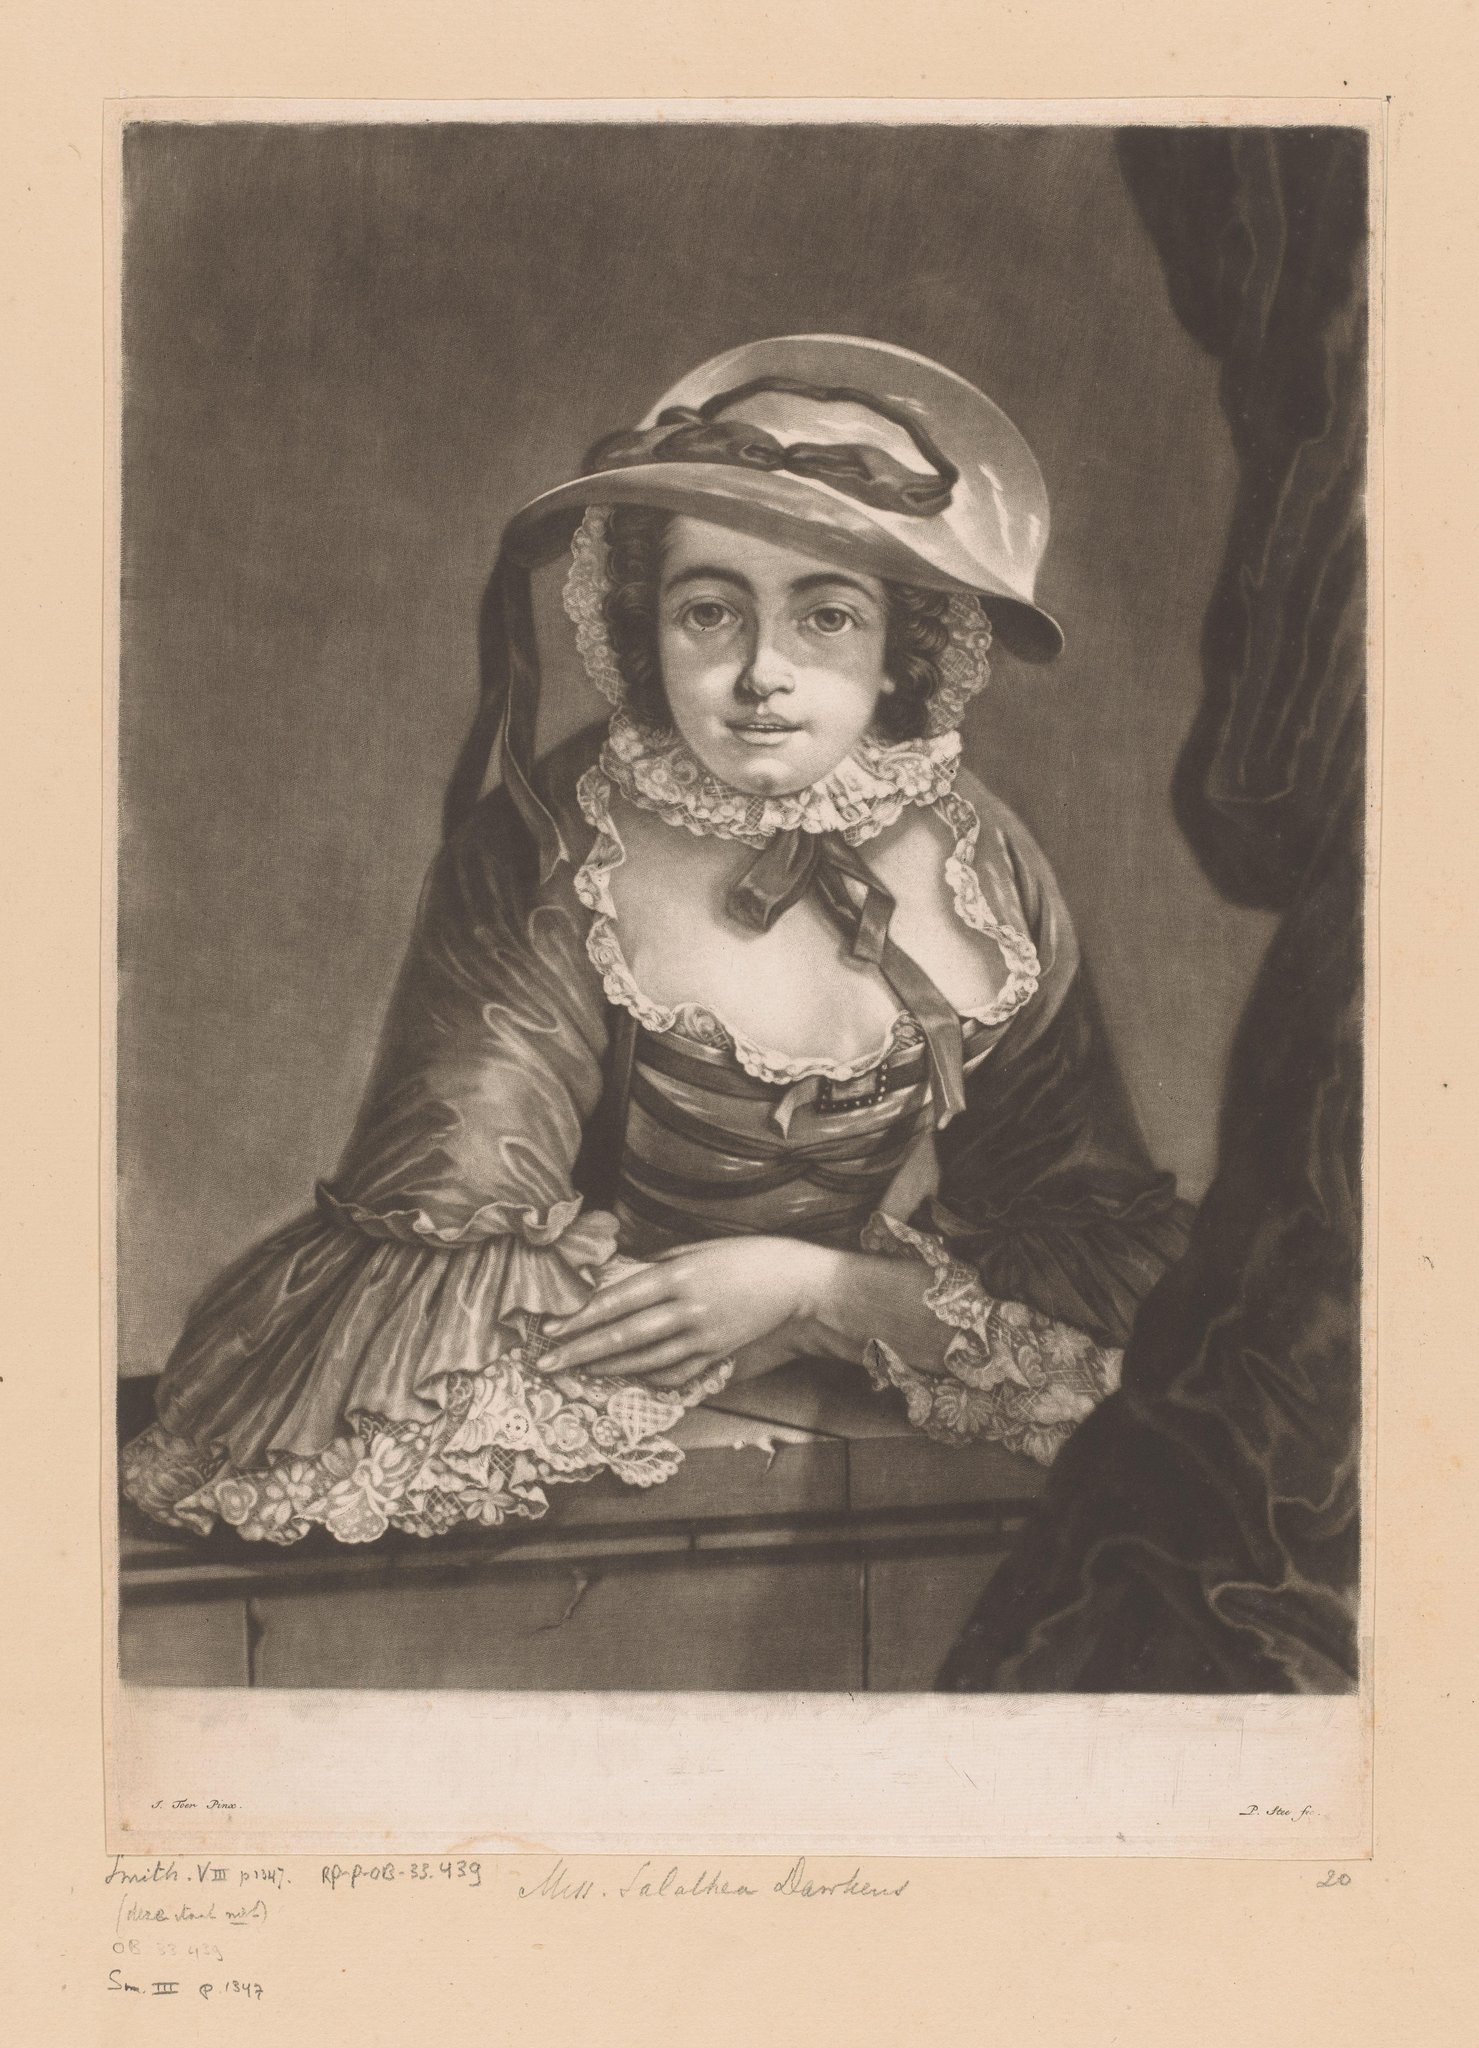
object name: print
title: Portret van Salathea Dawkens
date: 1770-1780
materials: paper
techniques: mezzotint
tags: historical persons - bb - woman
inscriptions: collector's mark: Lugt 240